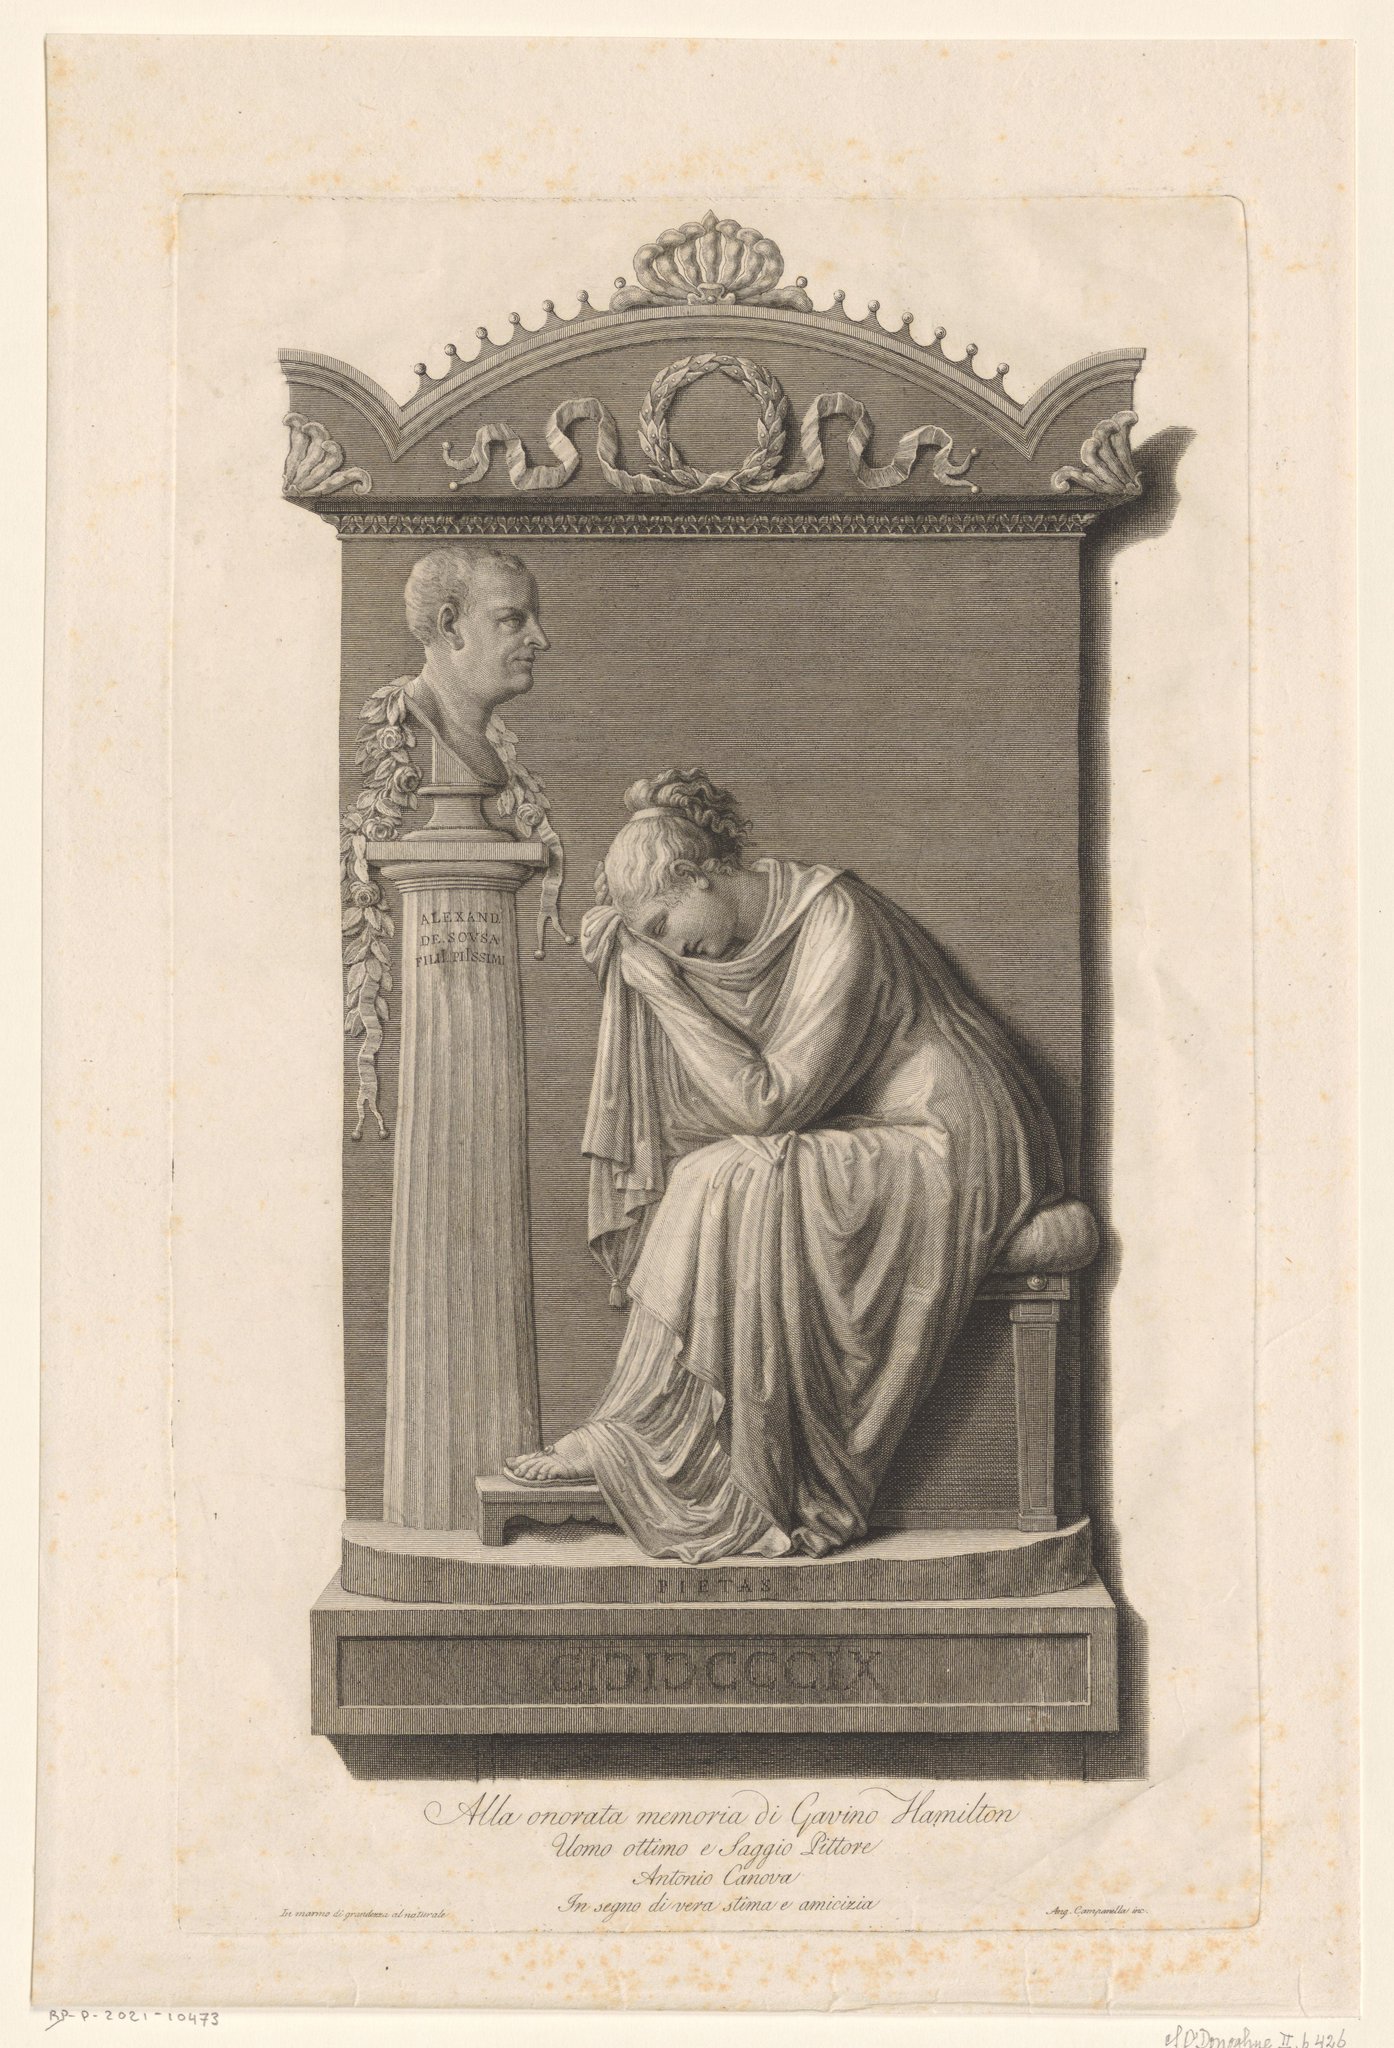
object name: print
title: Grafstèle van Alessandro de Sousa Holstein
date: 1809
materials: paper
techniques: engraving, etching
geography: italy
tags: historical persons, other kinds of grave-markers, e.g. cross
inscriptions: collector's mark: Lugt 2228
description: Naar een beeld van Antonio Canova dat zich bevindt in de Sant'Antonio dei Portoghesi te Rome.